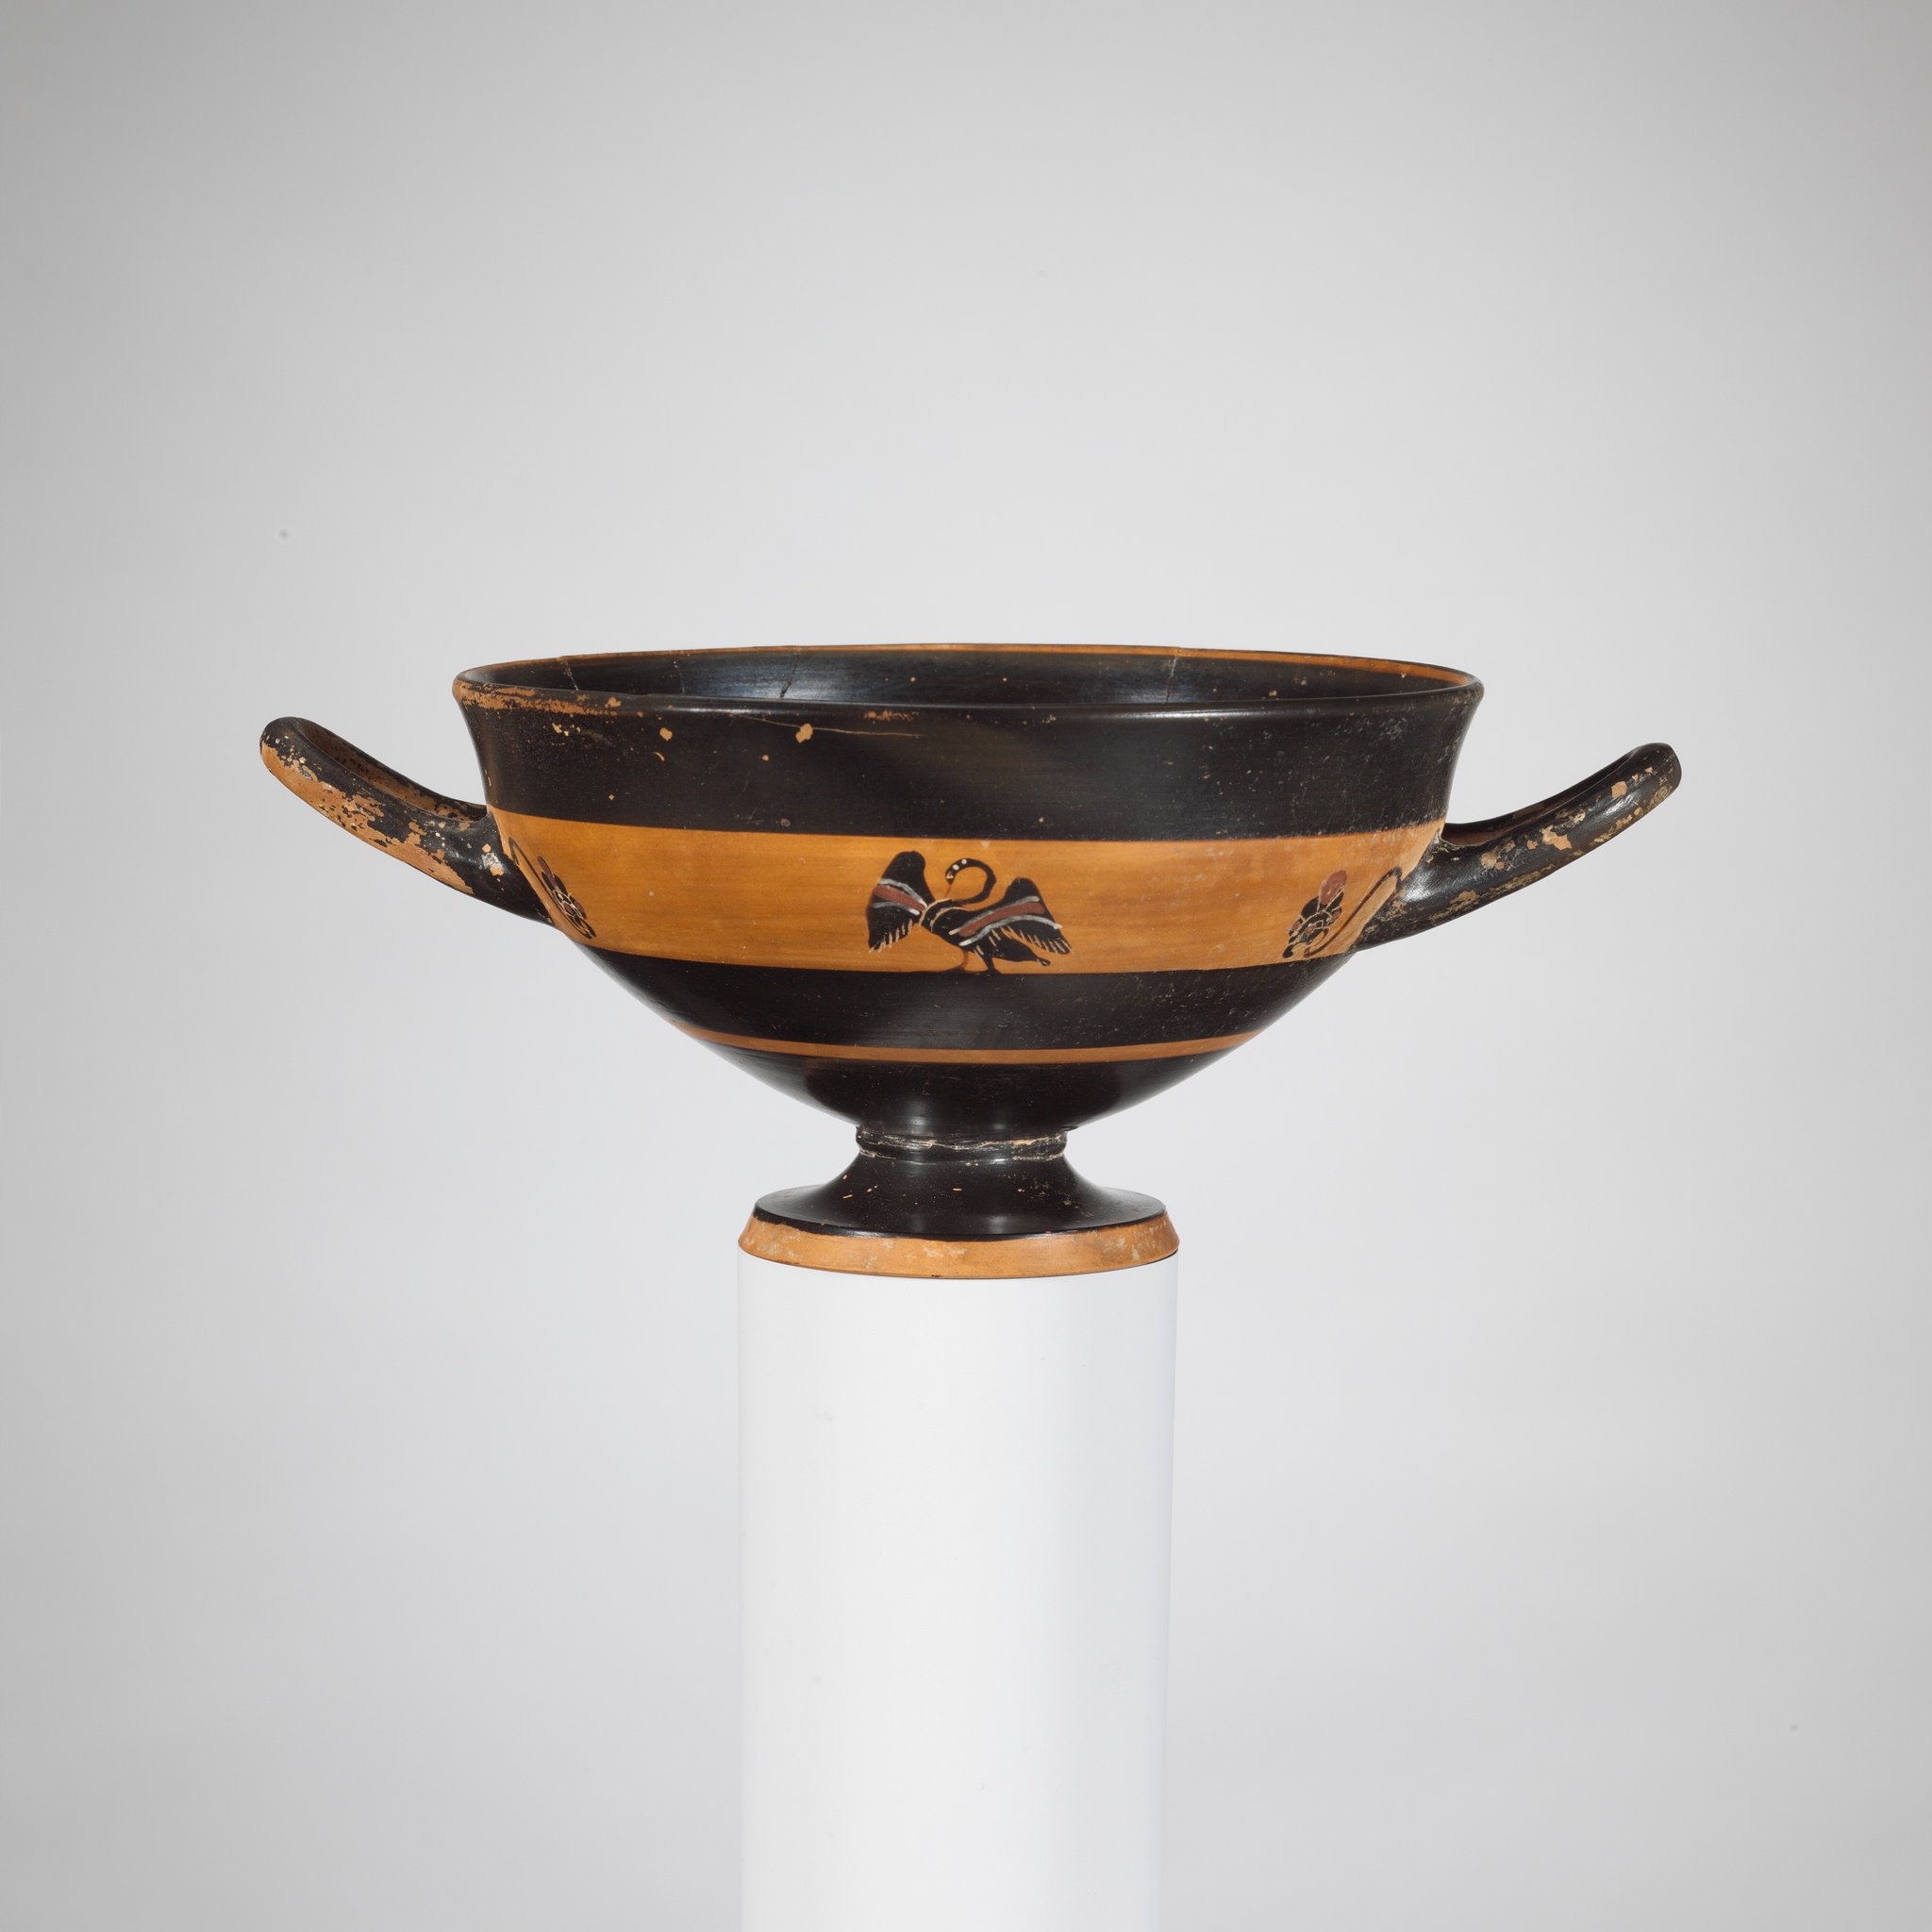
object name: skyphos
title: Terracotta skyphos (deep drinking cup)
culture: greek, attic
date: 530 BCE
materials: terracotta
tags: birds